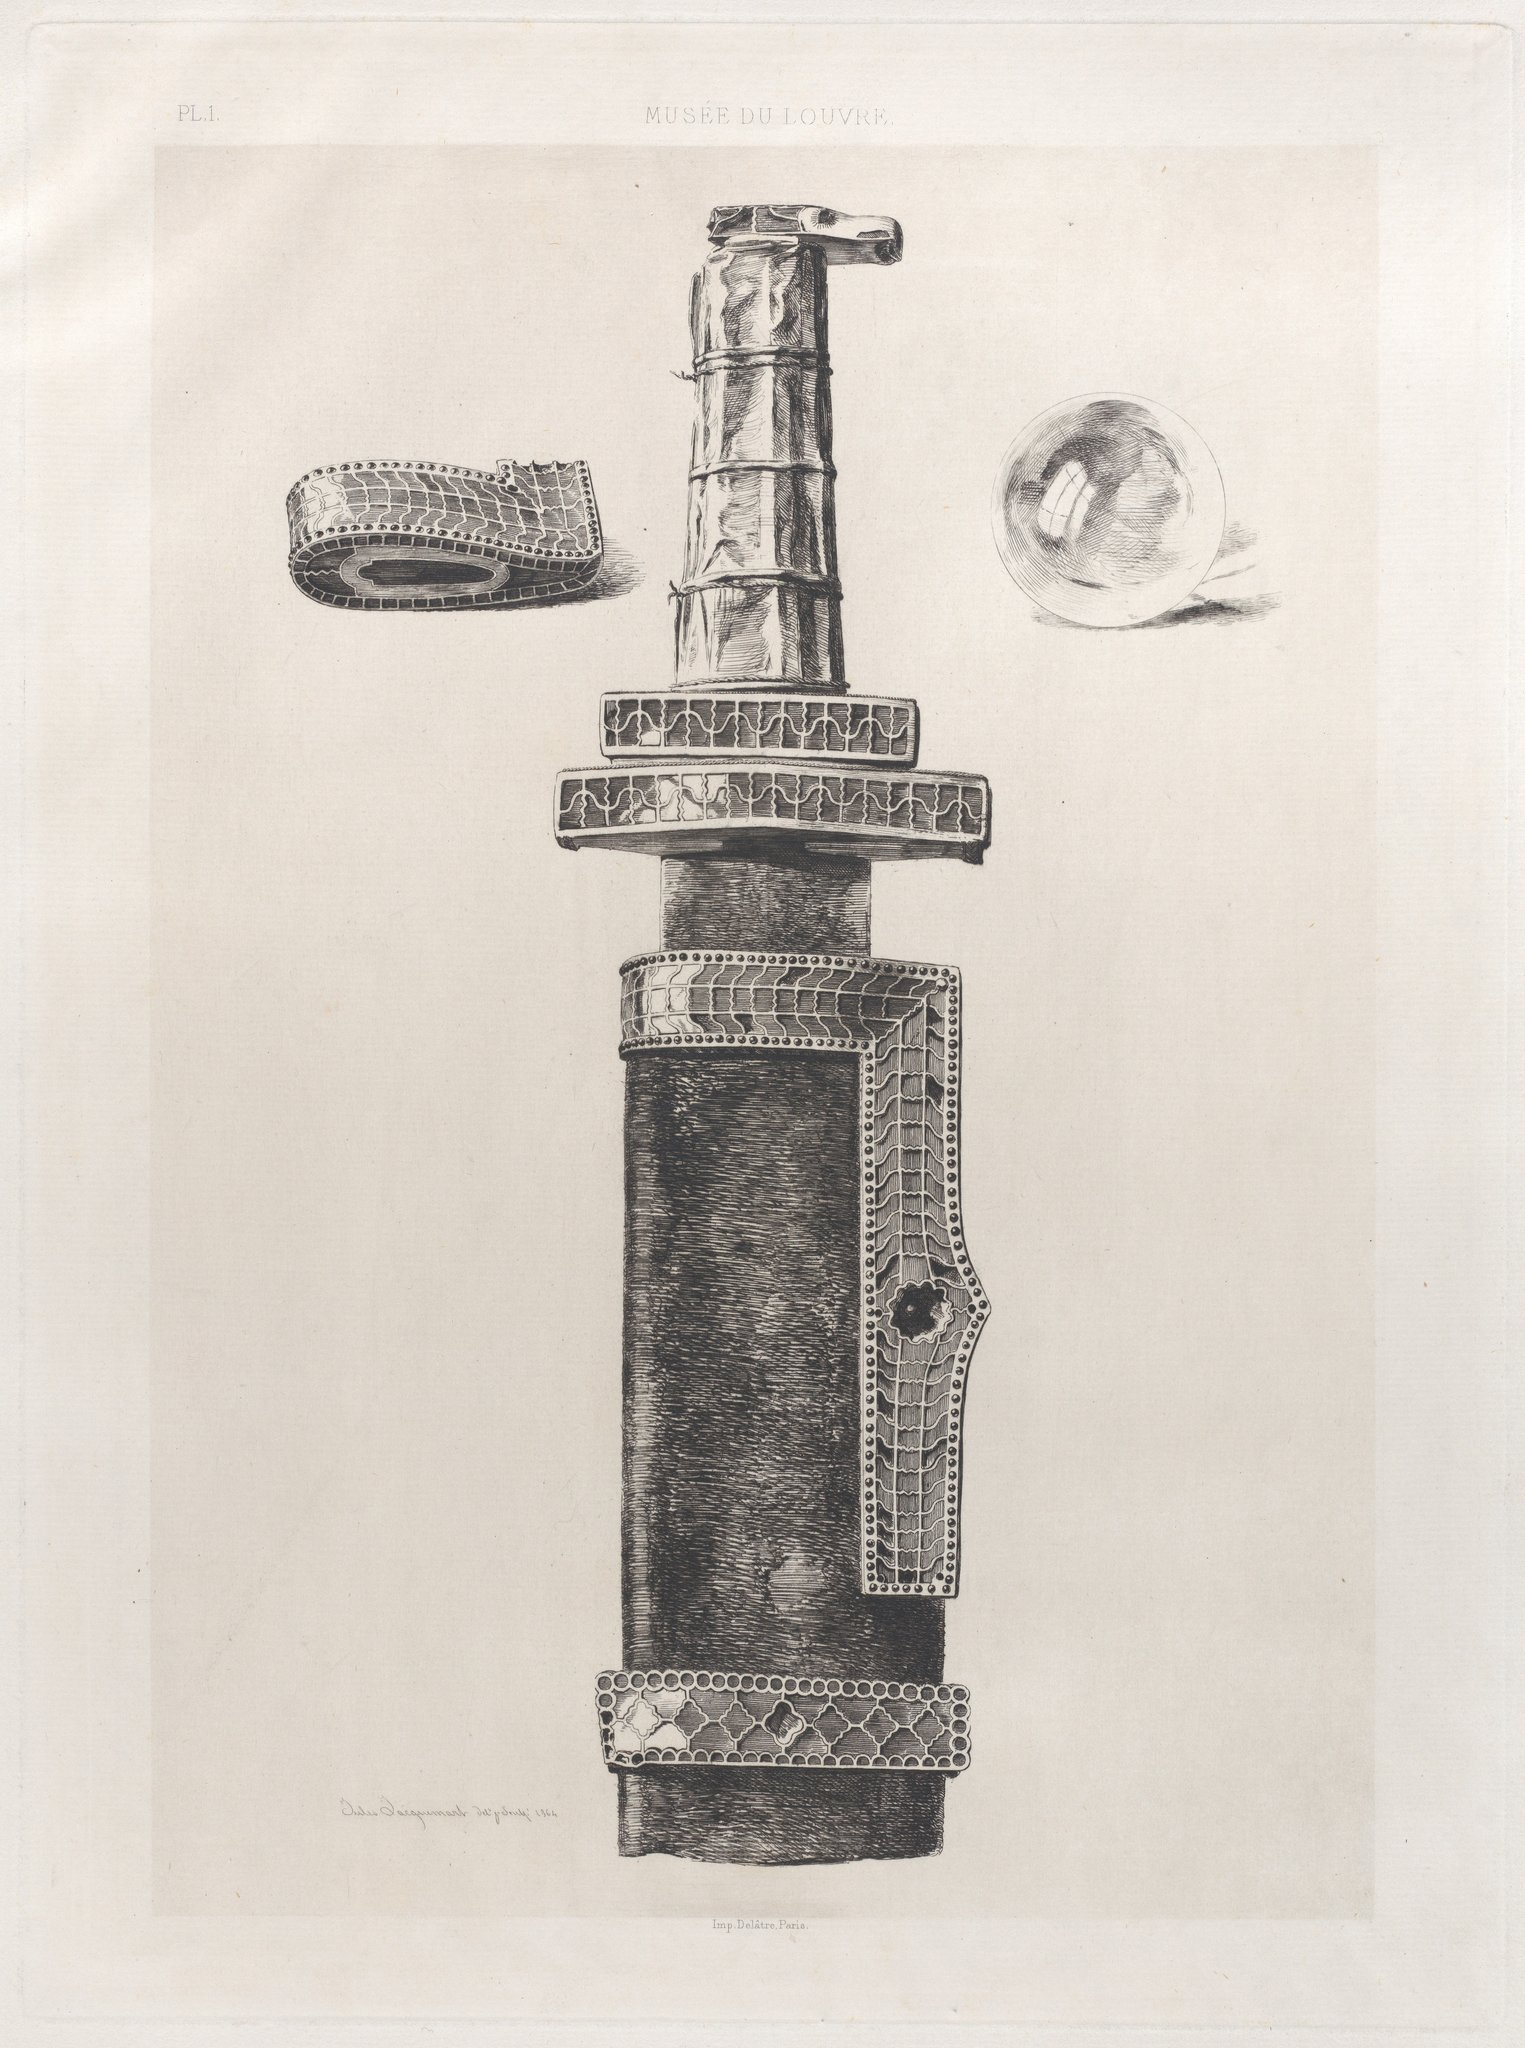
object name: print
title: Sword of Childeric and Chrystal Globe Found in His Grave at Tournay, 5th century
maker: jules-ferdinand jacquemart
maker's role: artist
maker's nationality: french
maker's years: 1837-1880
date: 1864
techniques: etching